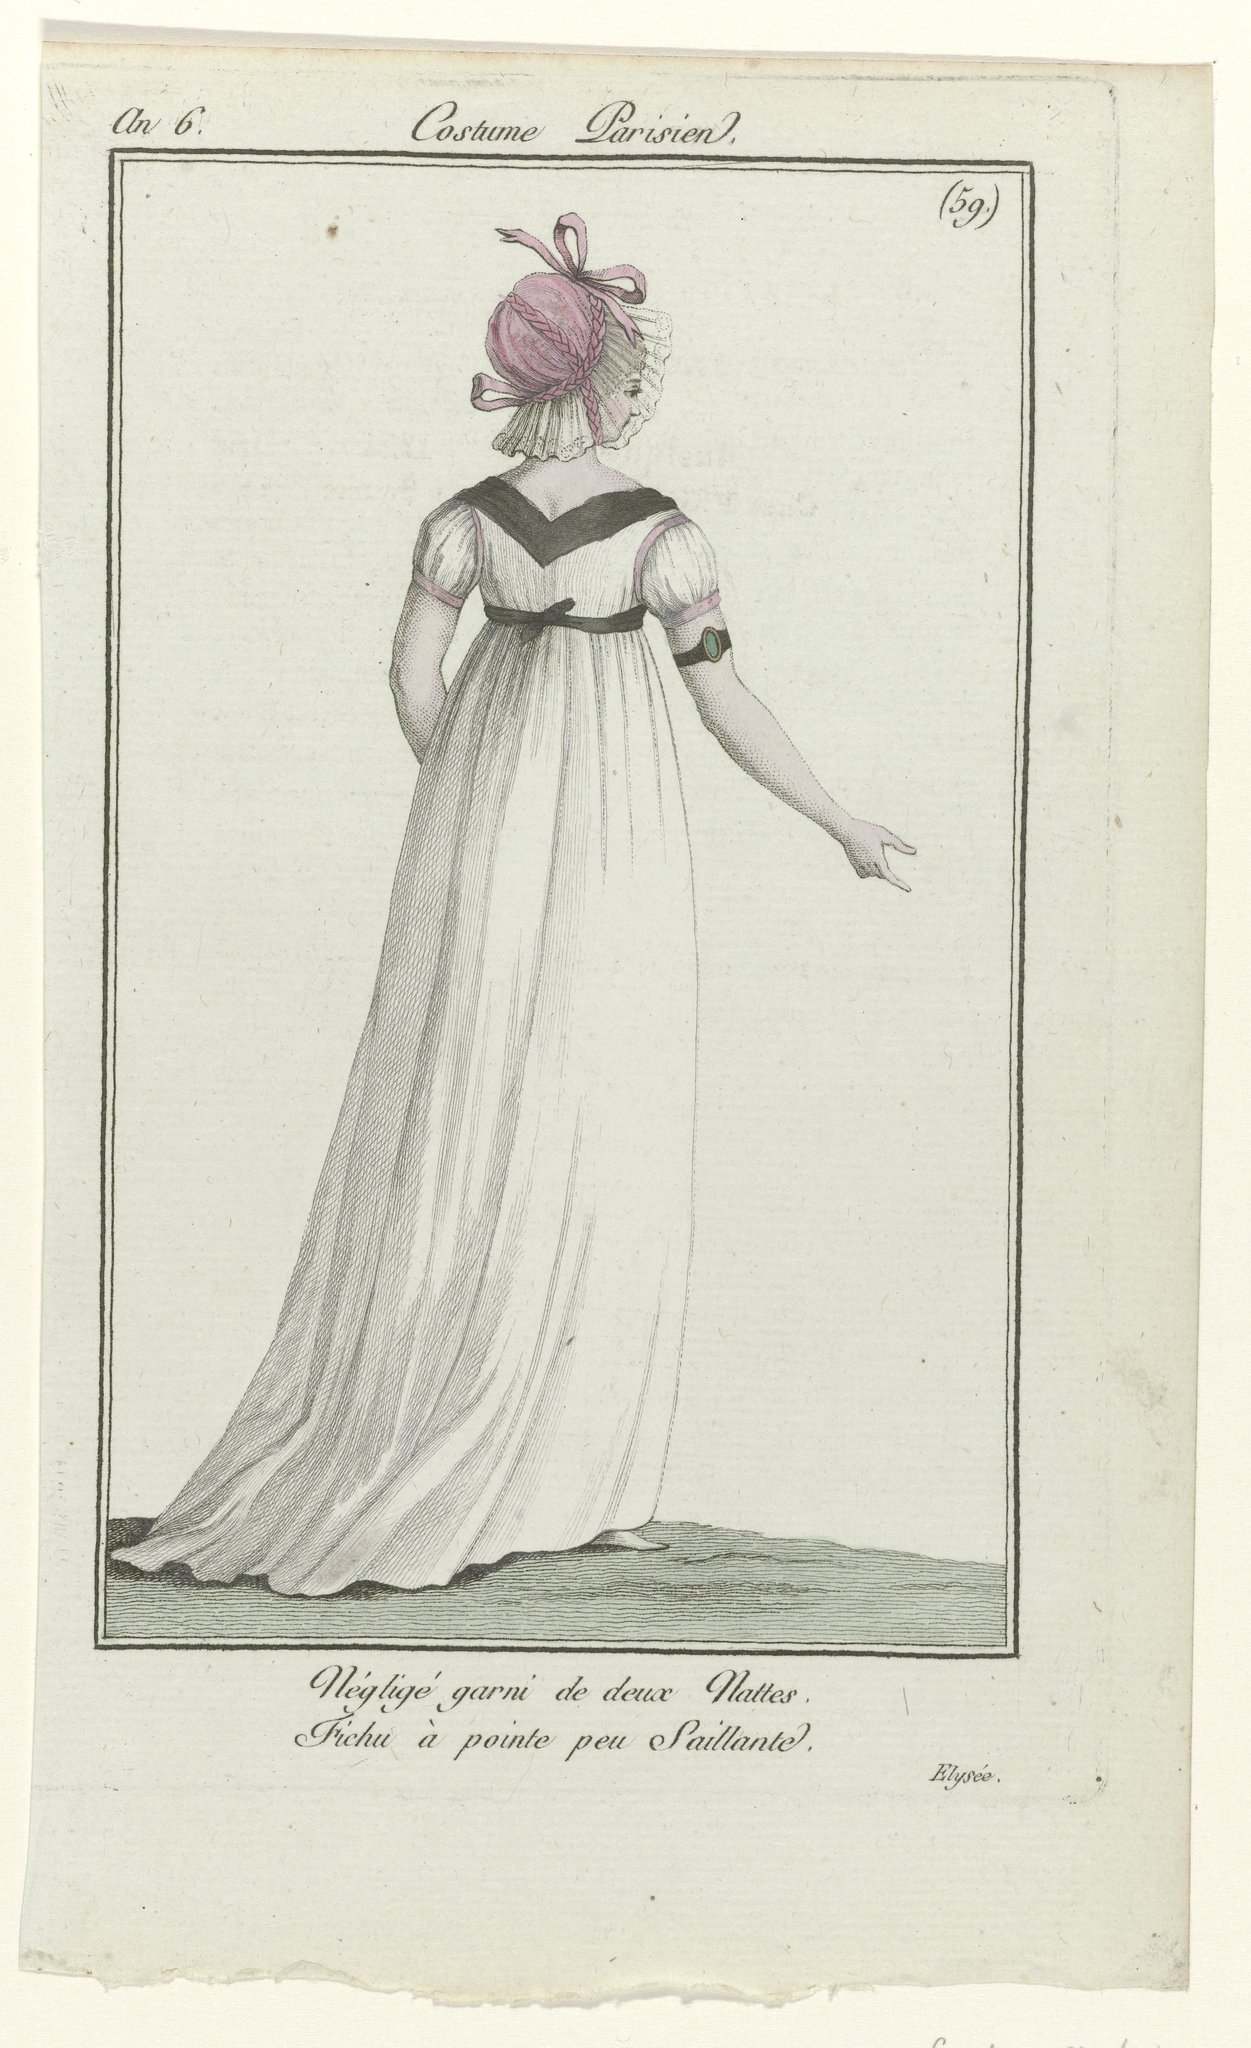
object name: fashion print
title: Journal des Dames et des Modes, Costume Parisien, 1 septembre 1798, An 6 (59) : Négligé garni de deux Nattes (...)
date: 1798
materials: paper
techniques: engraving, hand coloring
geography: paris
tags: head-gear: cap (+ women's clothes), fashion plates, shoes, sandals (+ women's clothes), dress, gown (+ women's clothes), piece of clothing covering the breast or décolleté (fichu) (+ women's clothes), bracelet, wristlet (+ women's clothes)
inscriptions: title: ‘Costume Parisien.’, caption: ‘Négligé garni de deux Nattes. Fichu à pointe peu Saillante. / Elysée.’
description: Staande vrouw, op de rug gezien, met op het hoofd een 'négligé' of muts, versierd met twee vlechten. Om de hals een fichu met een beetje uitstekende punt, op de rug vast geknoopt. Zij draagt een japon met korte mouwen en sleep. Om de rechter bovenarm een armband. Volgens het onderschrift is dit kostuum naar het leven getekend in de 'Elysée'. De prent maakt deel uit van het modetijdschrift Journal des Dames et des Modes, uitgegeven door Sellèque, Parijs, 1797-1839.